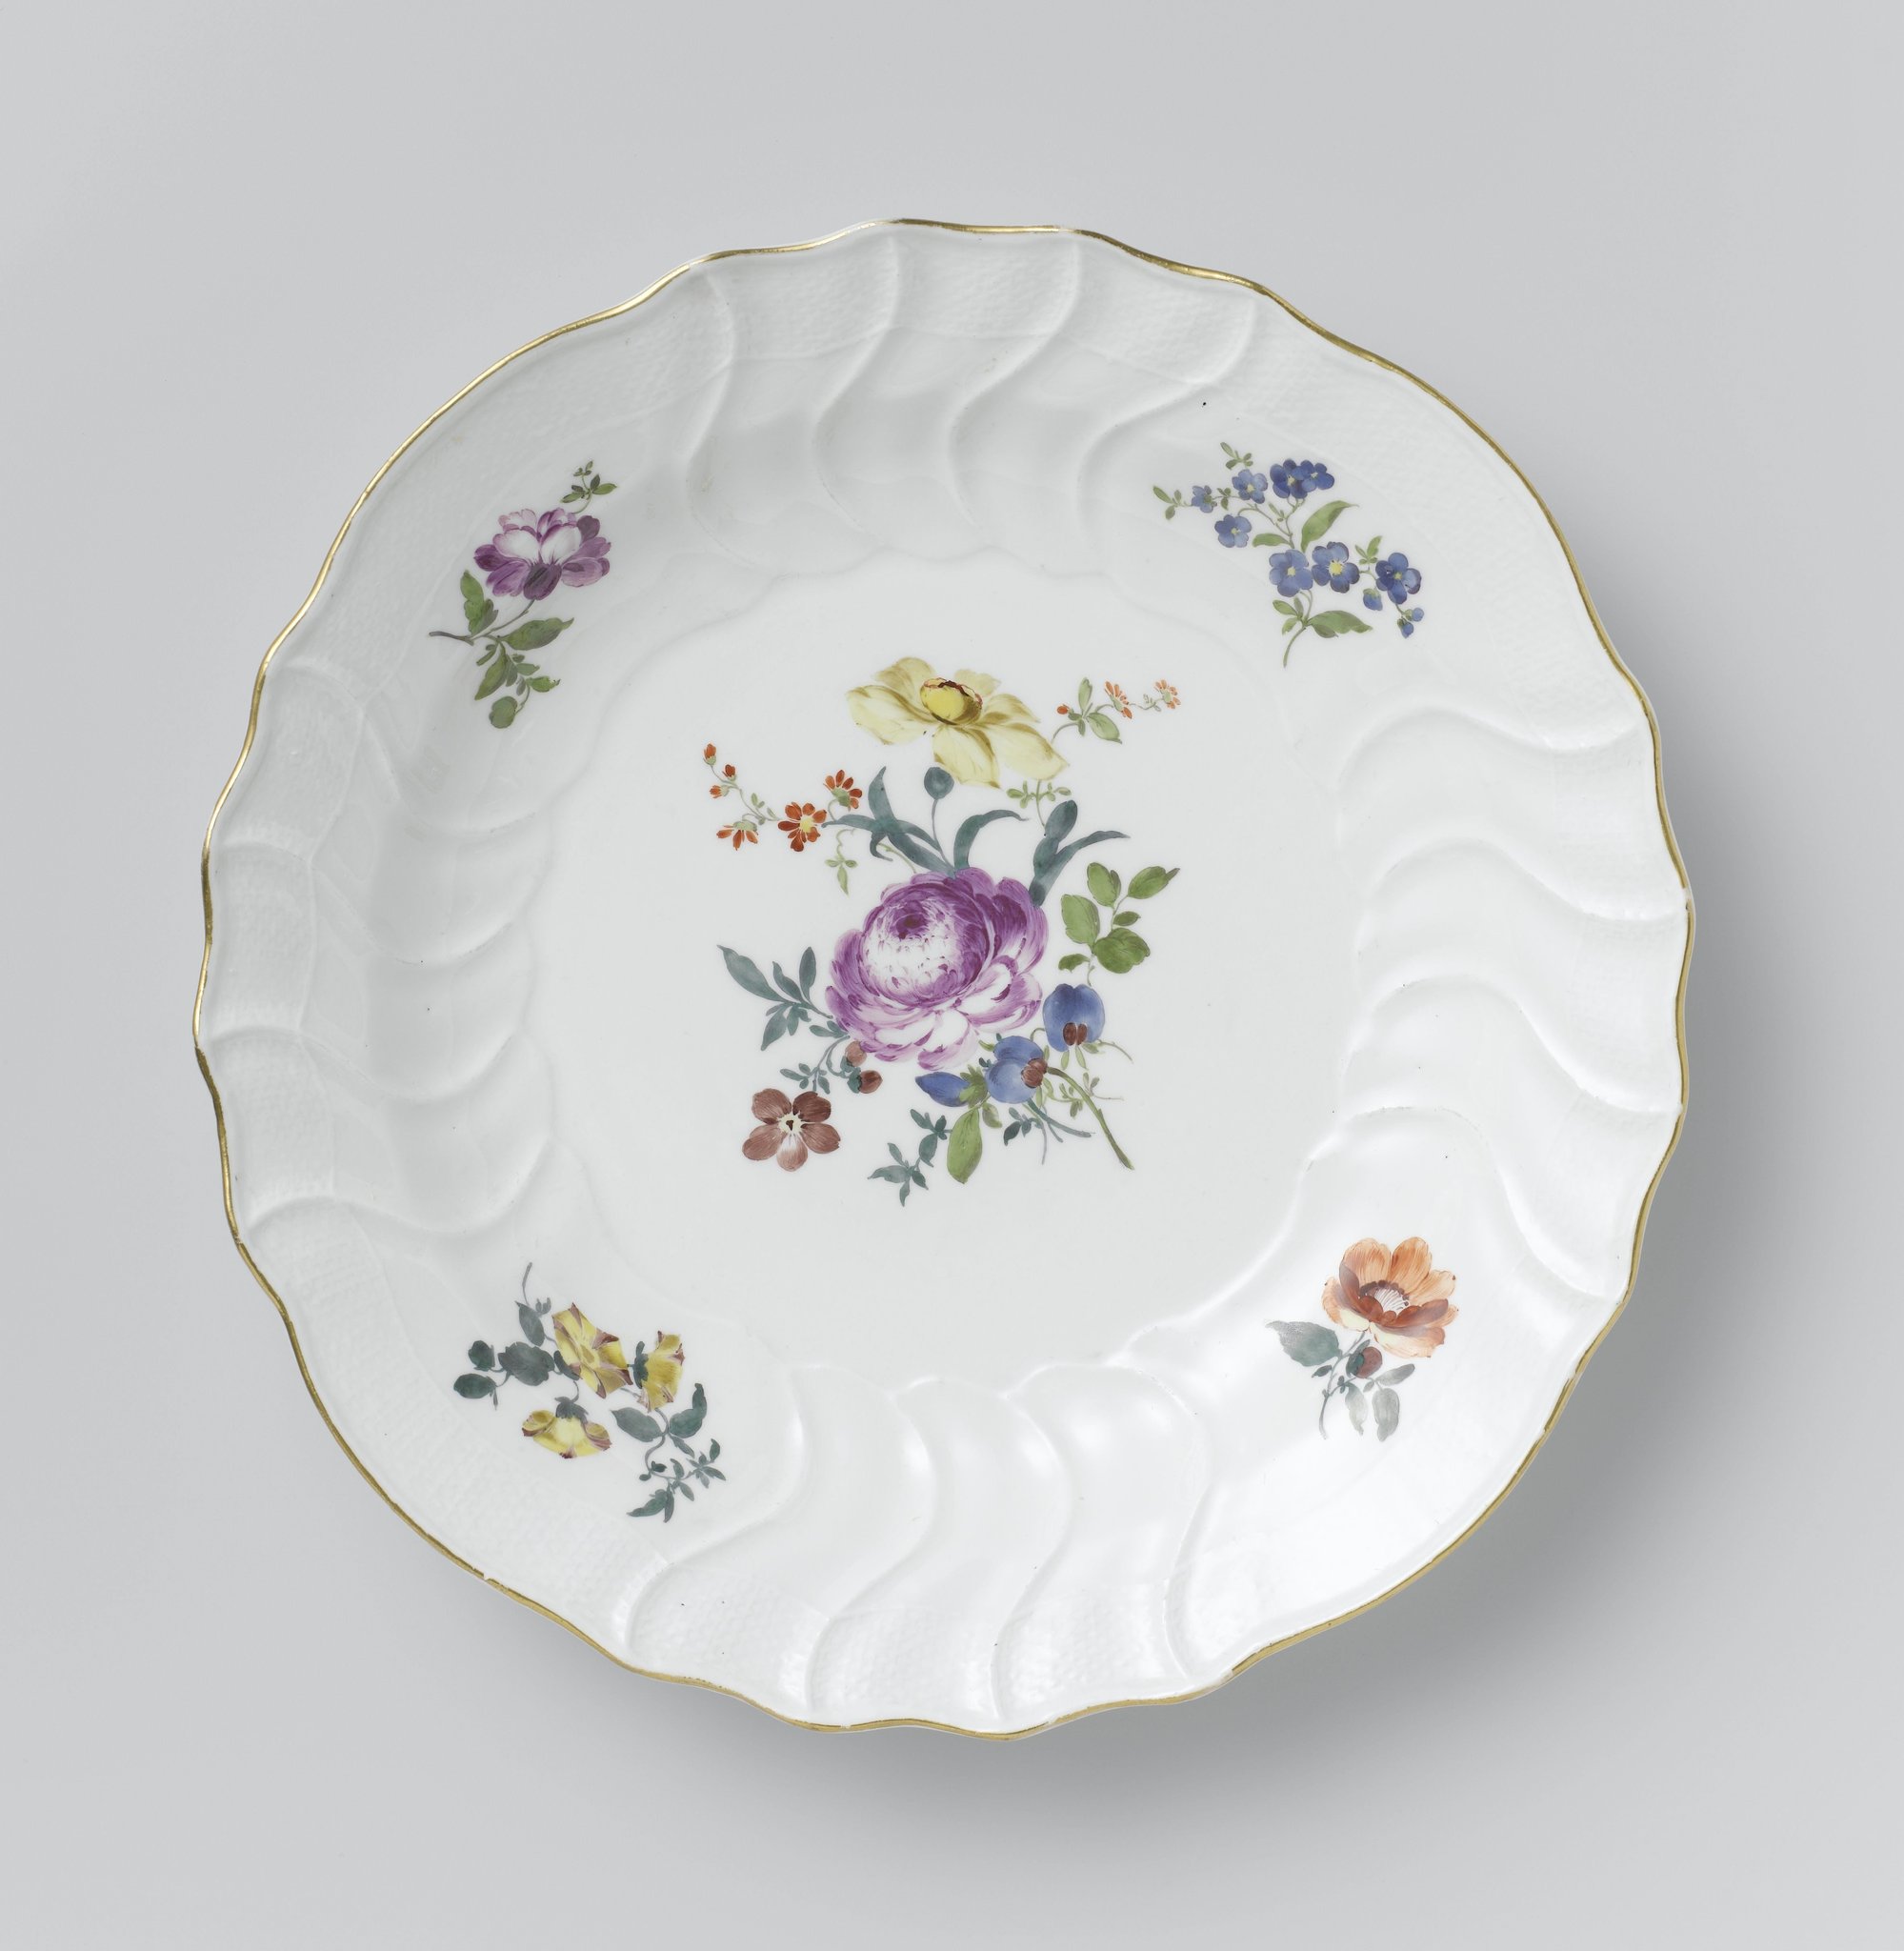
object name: eating drinking utensil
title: Schotel, veelkleurig beschilderd met Deutsche Blumen, insekten en vruchten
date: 1750-1760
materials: porcelain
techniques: painted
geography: meissen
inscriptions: factory mark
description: Ronde schotel van beschilderd porselein. De schotel is beschilderd met Deutsche Blumen, insekten en vruchten. De rand is in reliëf versierd met het Neuozier-patroon. De schotel is gemerkt en hoort bij een servies (BK-17474-1 t/m BK-17474-253).